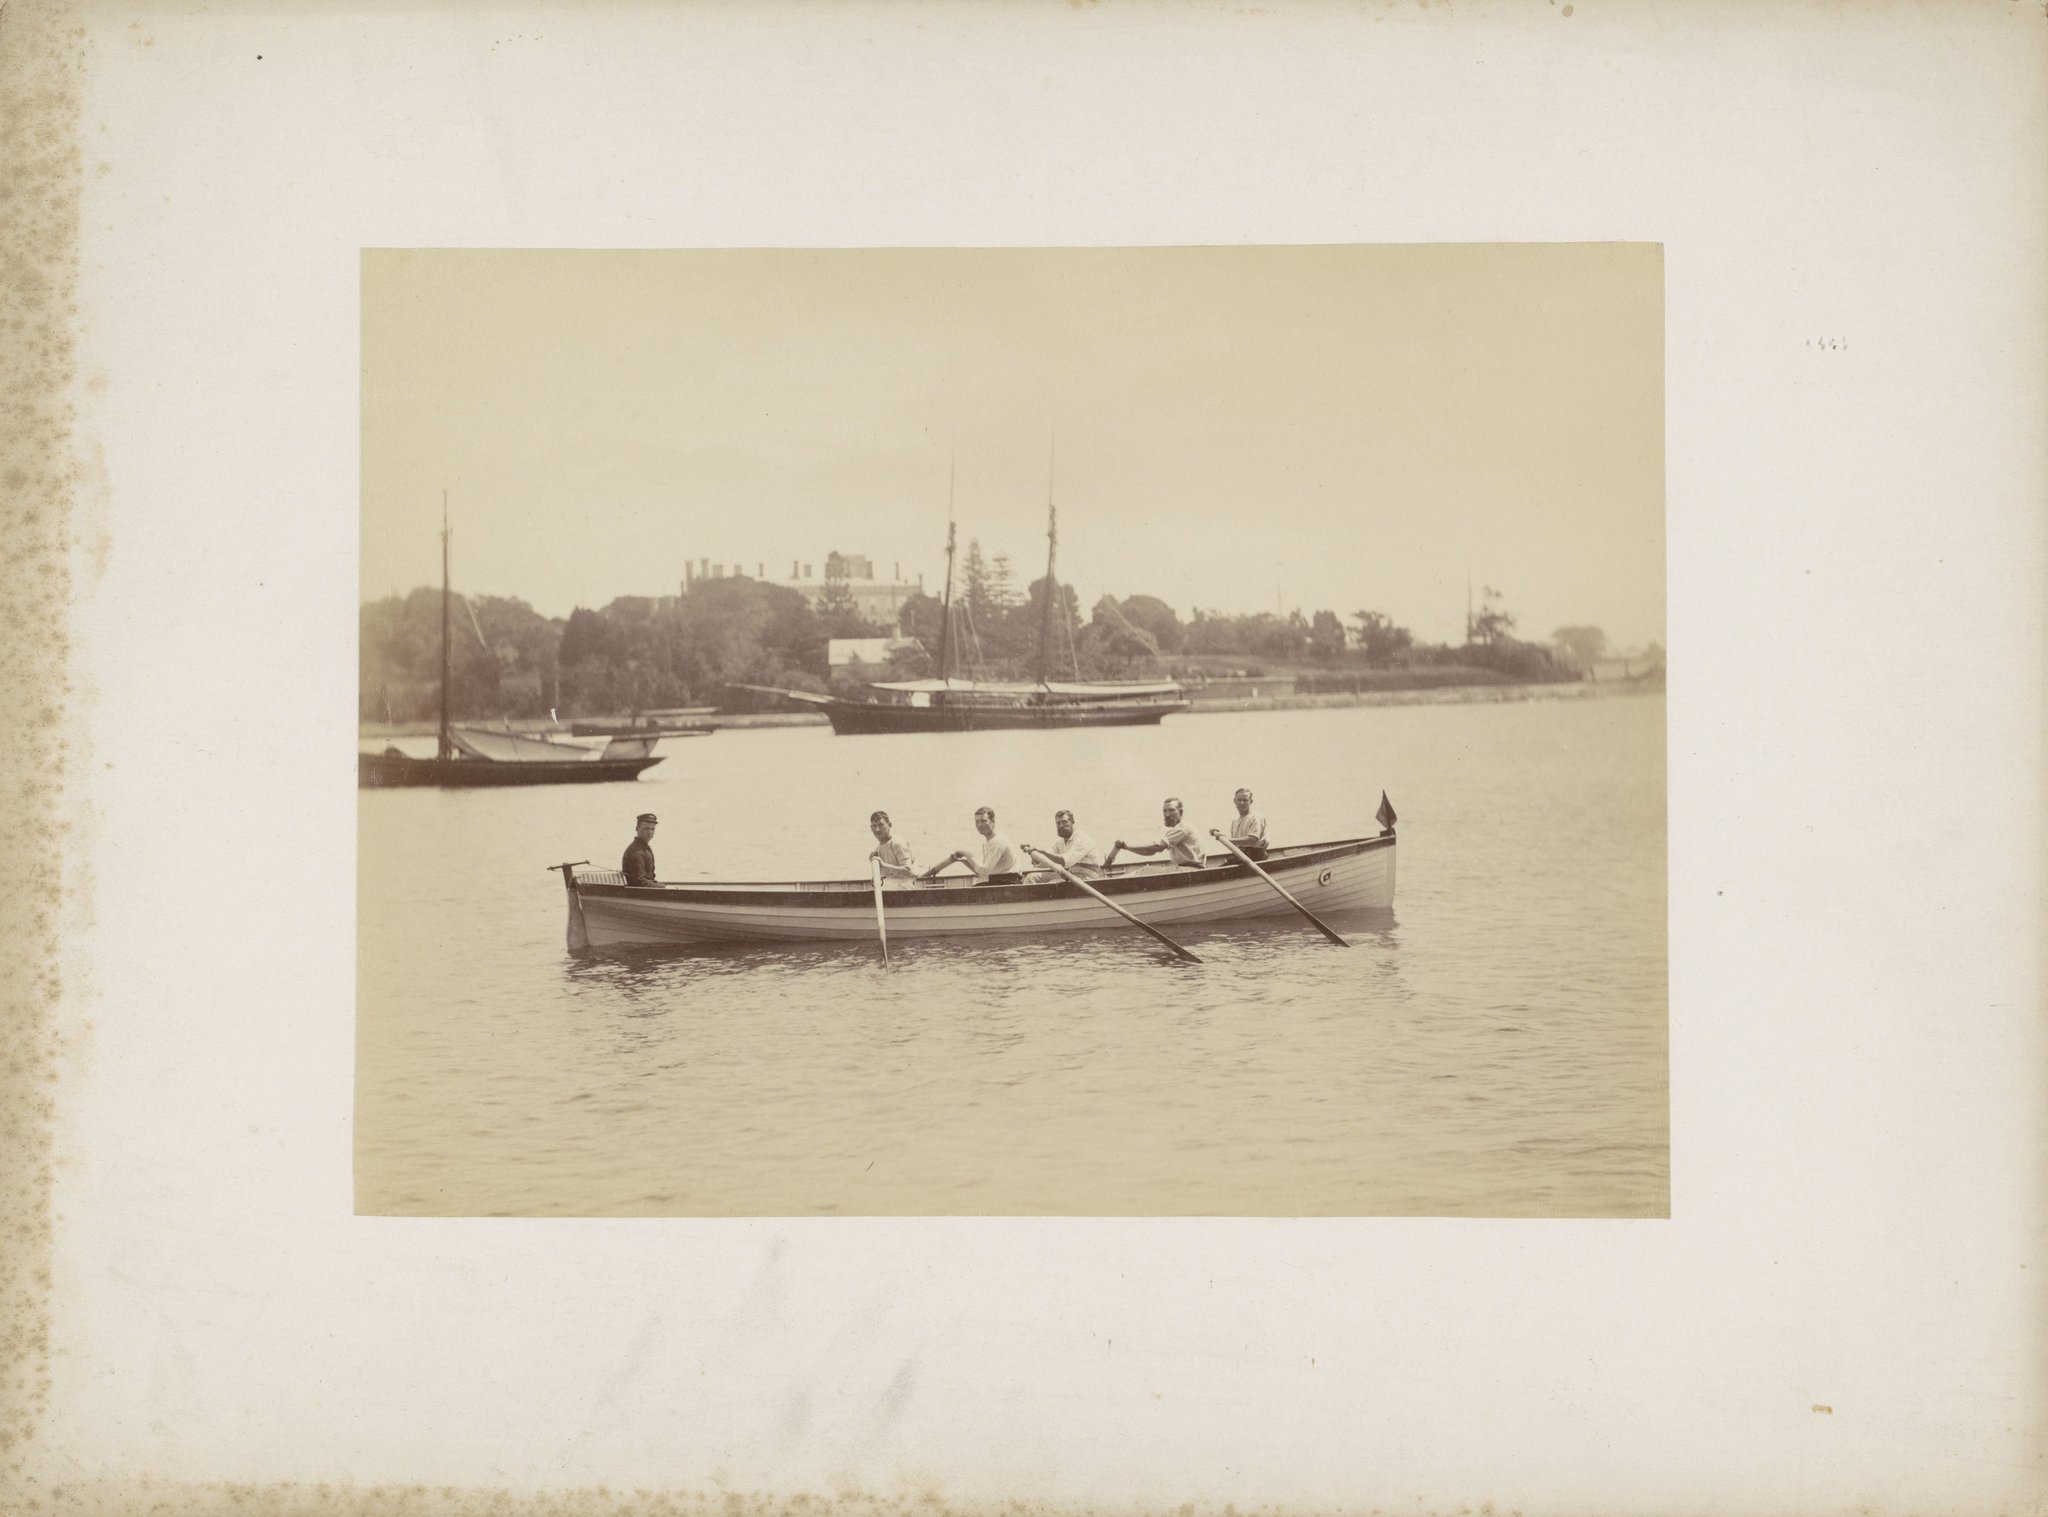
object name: album leaf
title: Zes mannen in een roeiboot langs de kust, vermoedelijk bij Sydney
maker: charles bayliss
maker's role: fotograaf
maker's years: 1850-1897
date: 1890-1910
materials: cardboard, paper, photographic support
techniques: albumen print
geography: sydney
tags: rowing-boat, canoe, etc.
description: Onderdeel van Reisalbum met foto's van bezienswaardigheden in Sydney.